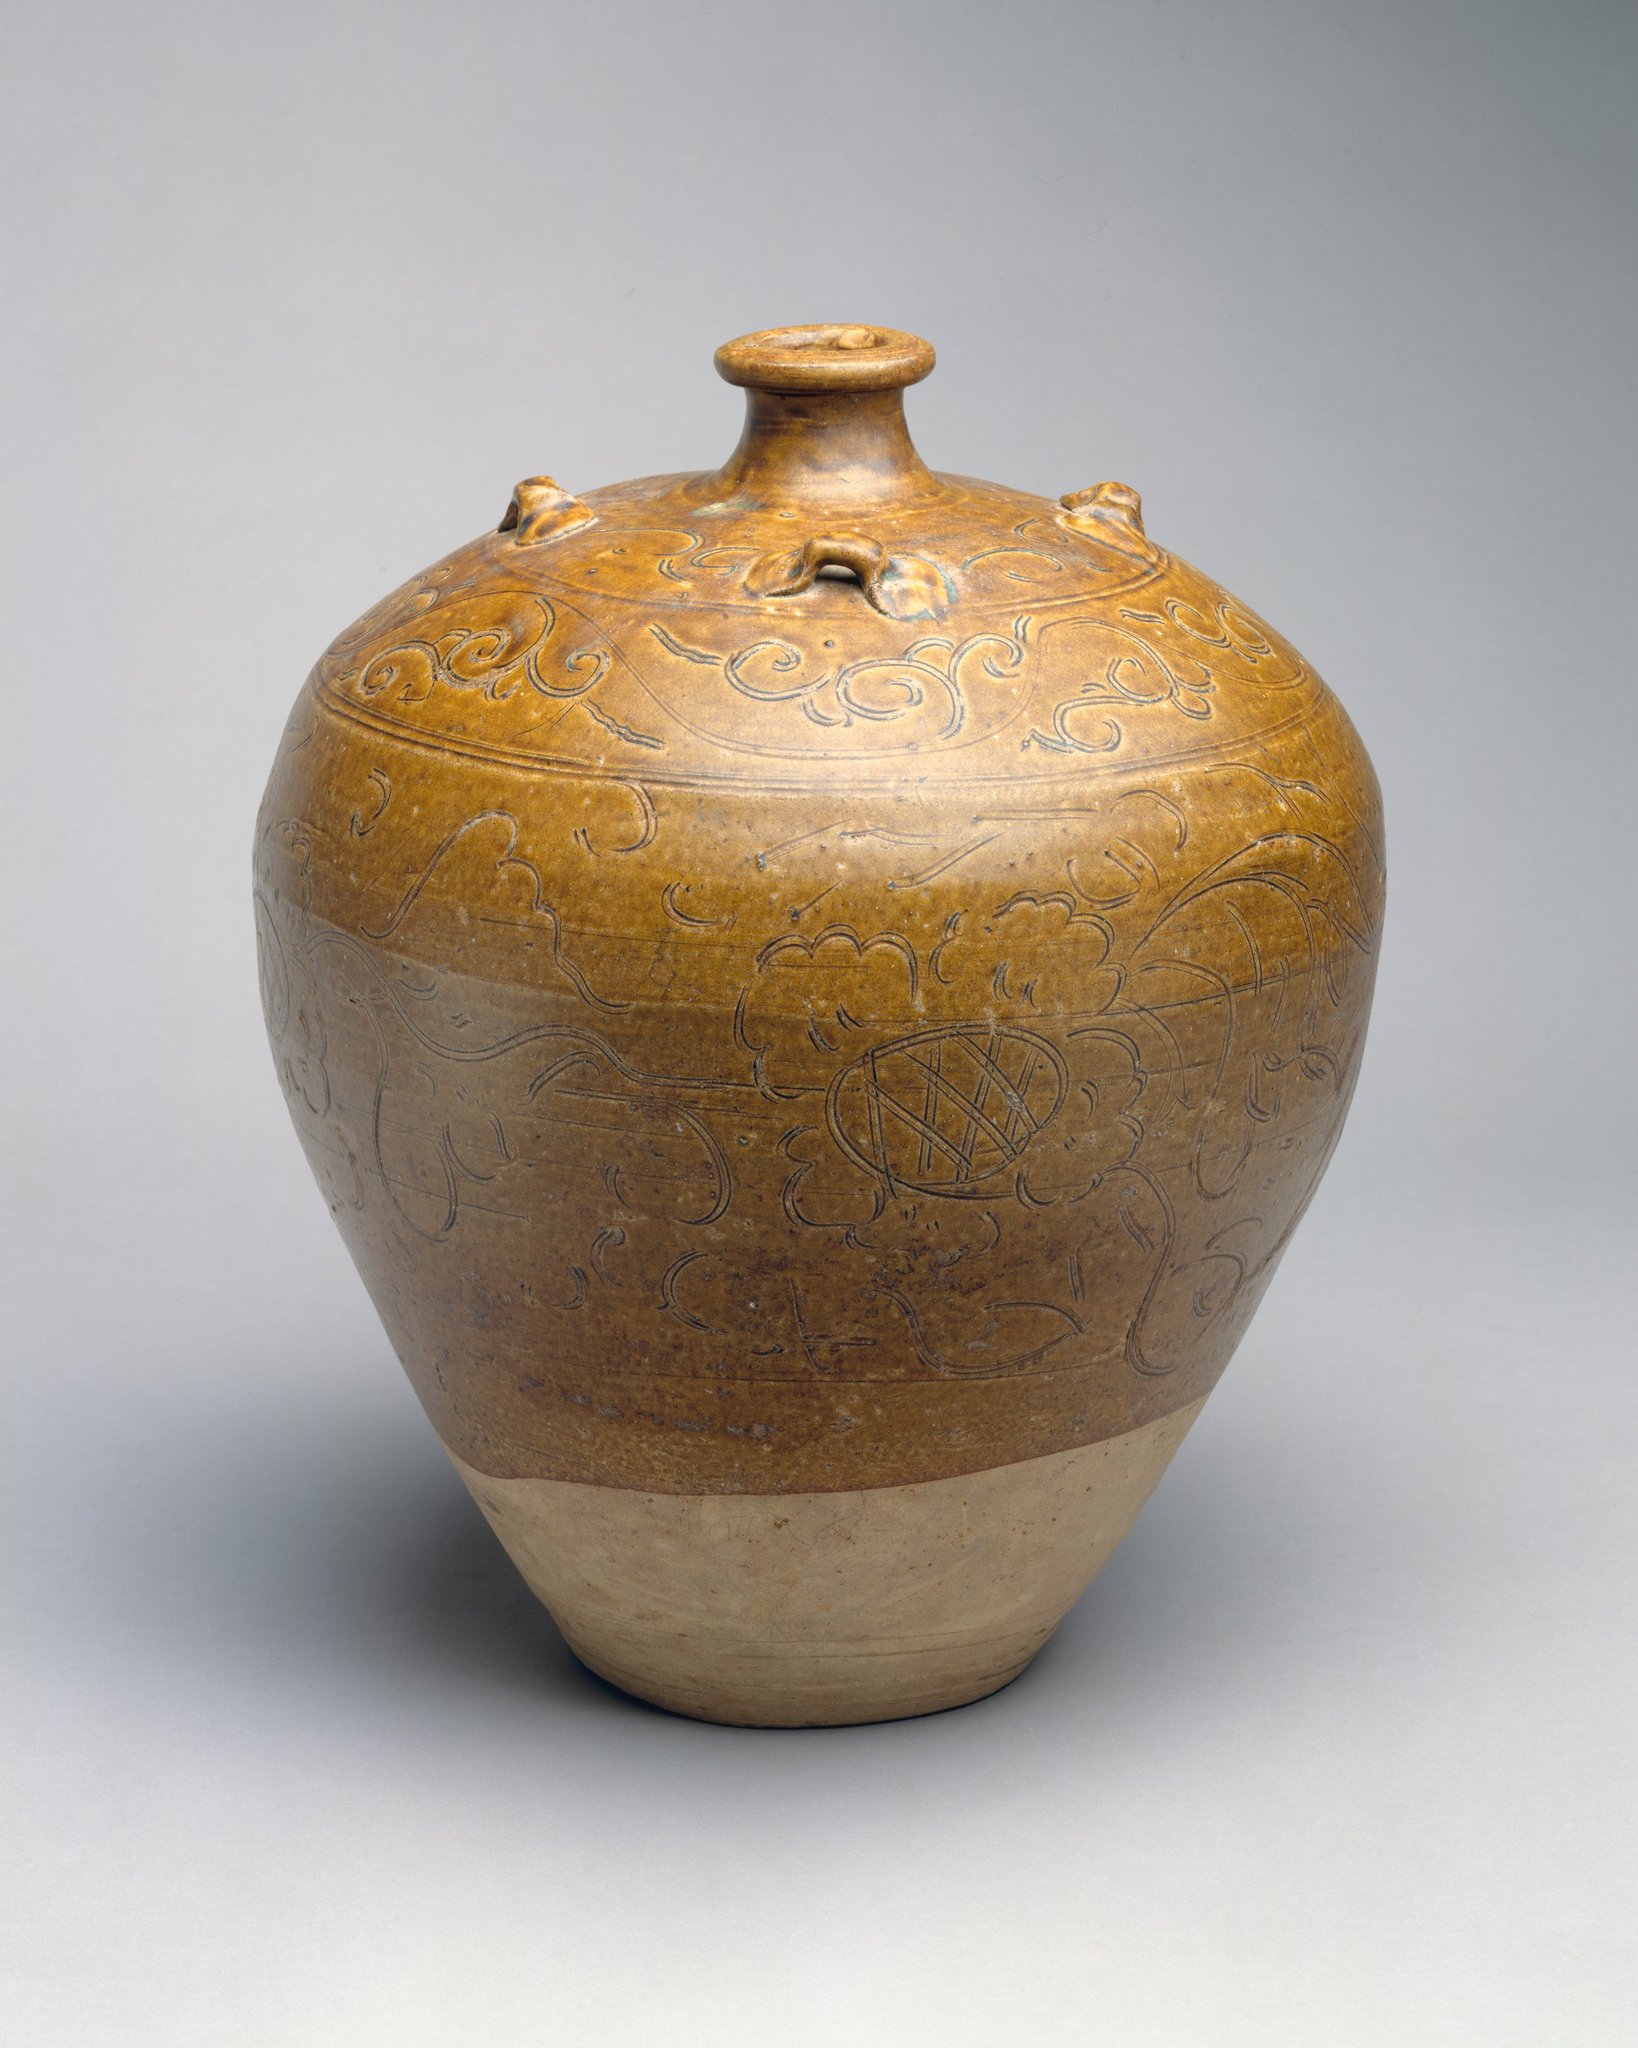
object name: jar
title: Large Incised Jar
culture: vietnamese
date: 1401-1600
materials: glaze, stoneware